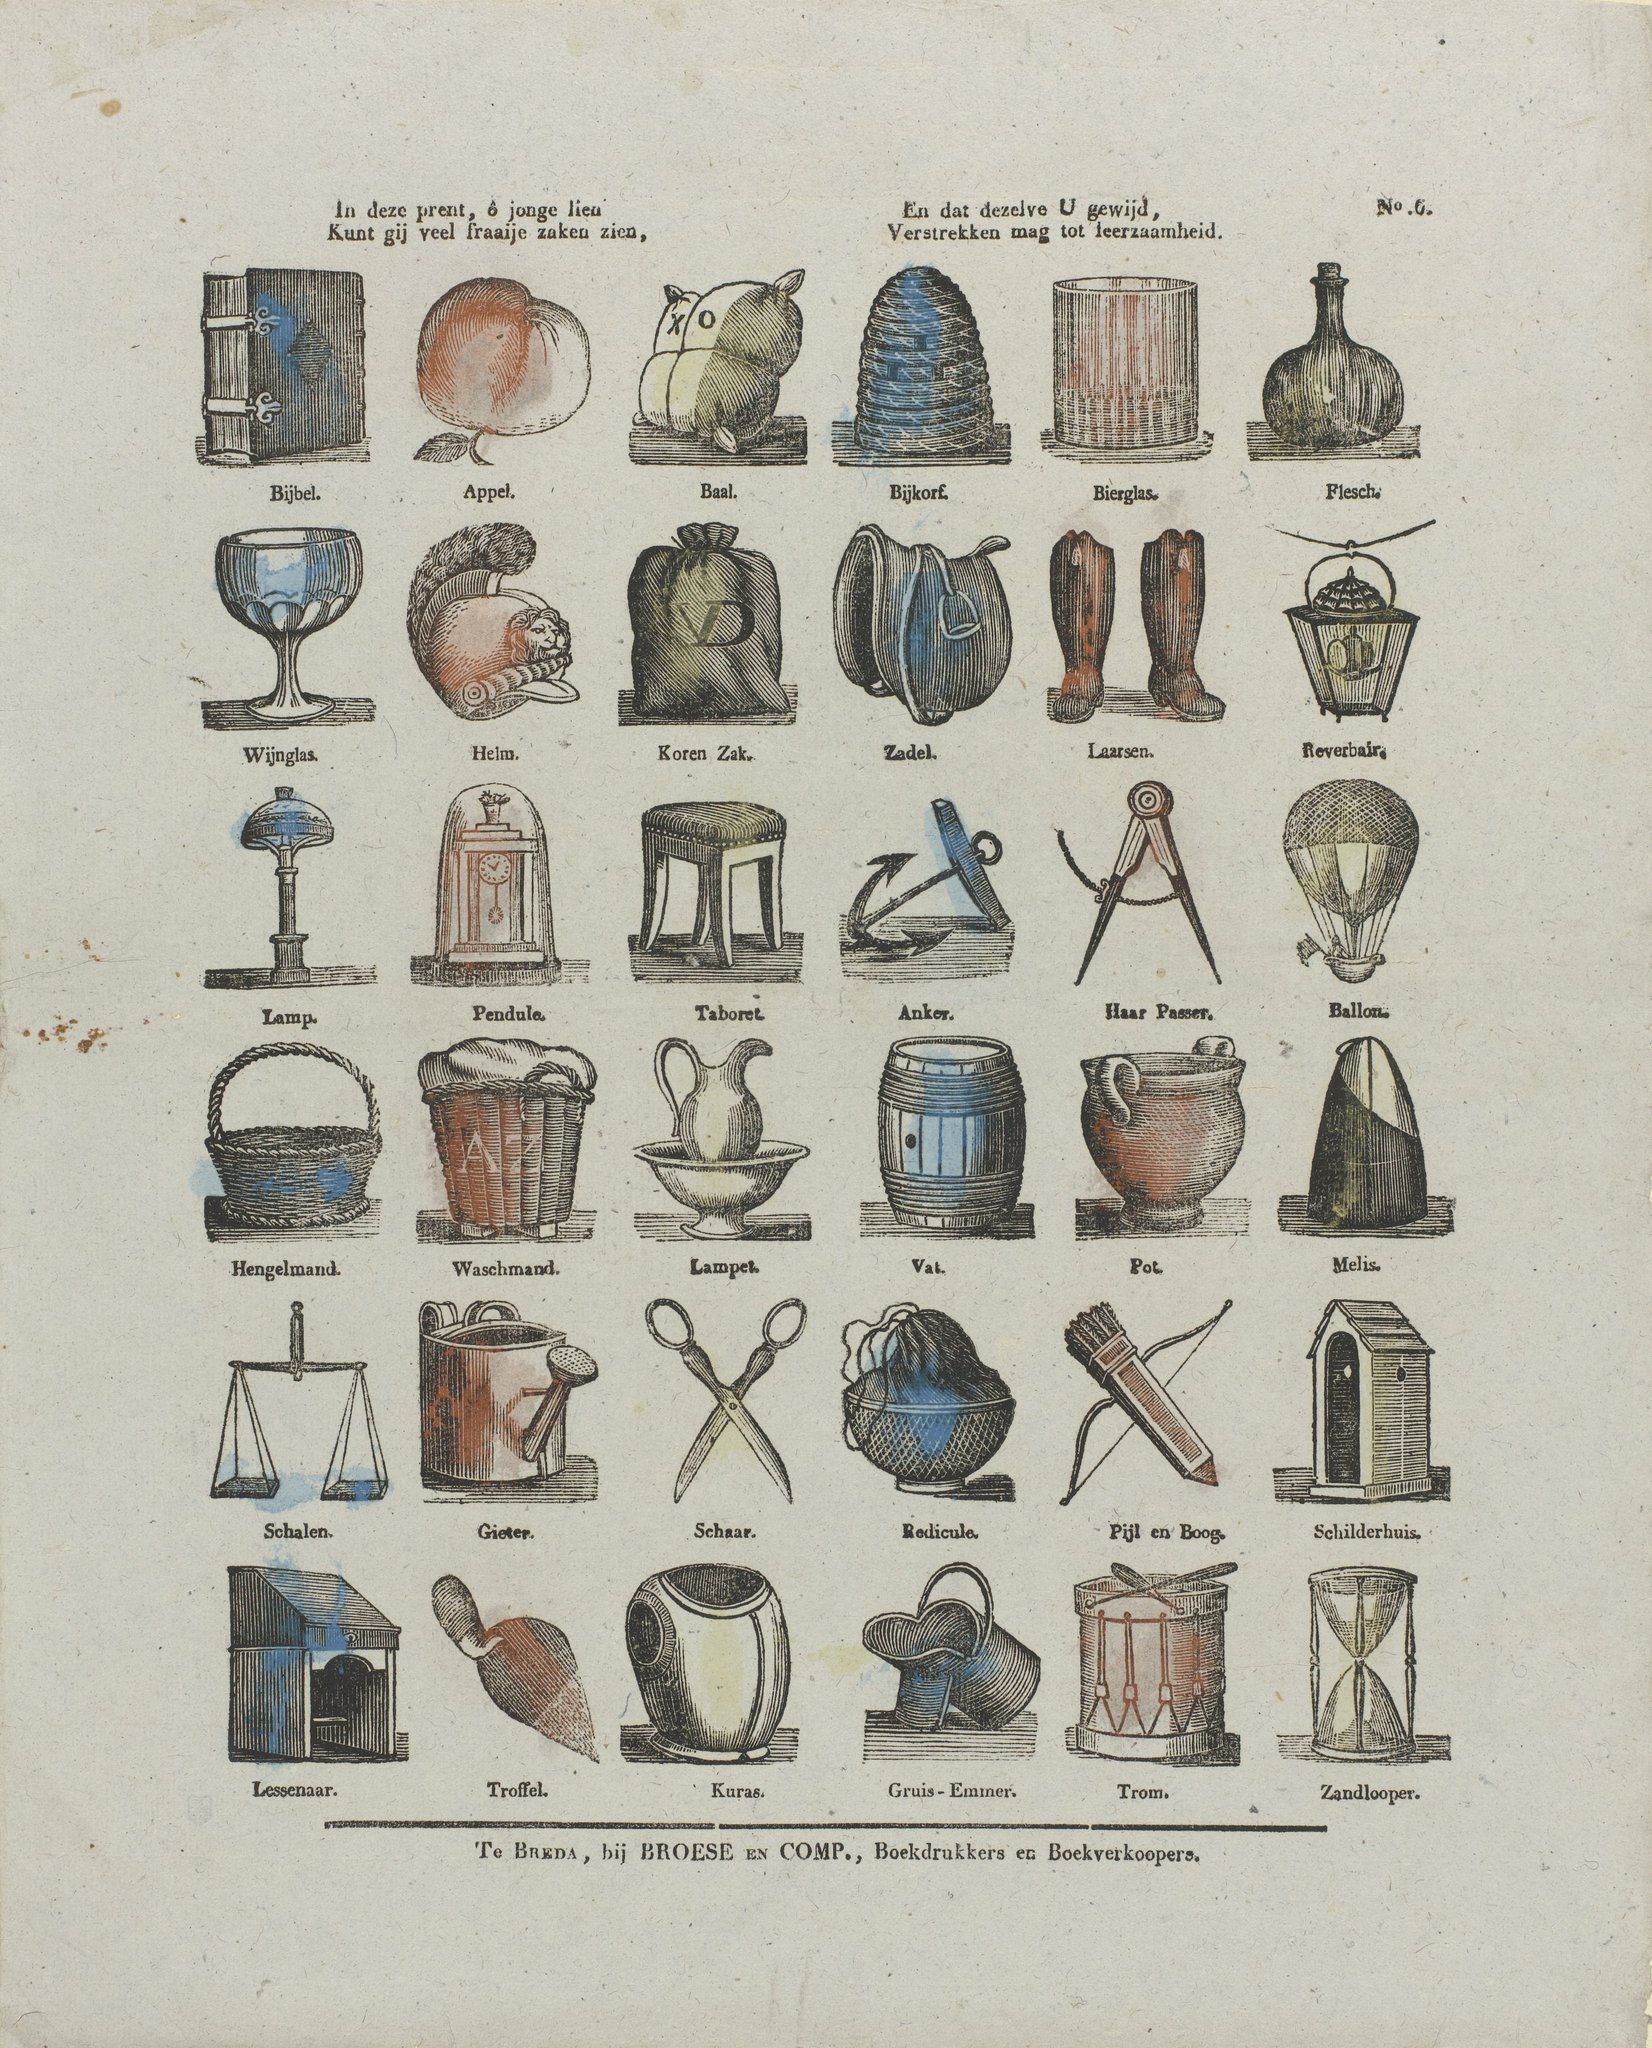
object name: print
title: In deze prent, ô jonge lien / Kunt gij veel fraaije zaken zien, / En dat dezelve u gewijd, / Verstrekken mag tot leerzaamheid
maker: Anonymous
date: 1828-1853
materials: paper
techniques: colour, letterpress printing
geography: breda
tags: bible, drum (musical instrument), bee-hive, glass of beer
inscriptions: collector's mark: Lugt 2760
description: Blad met 36 voorstellingen voorwerpen, waaronder een Bijbel, een bijenkorf, een luchtballon, een lampet en een trommel. Onder elke voorstelling een onderschrift. Genummerd rechtsboven: No. 6.